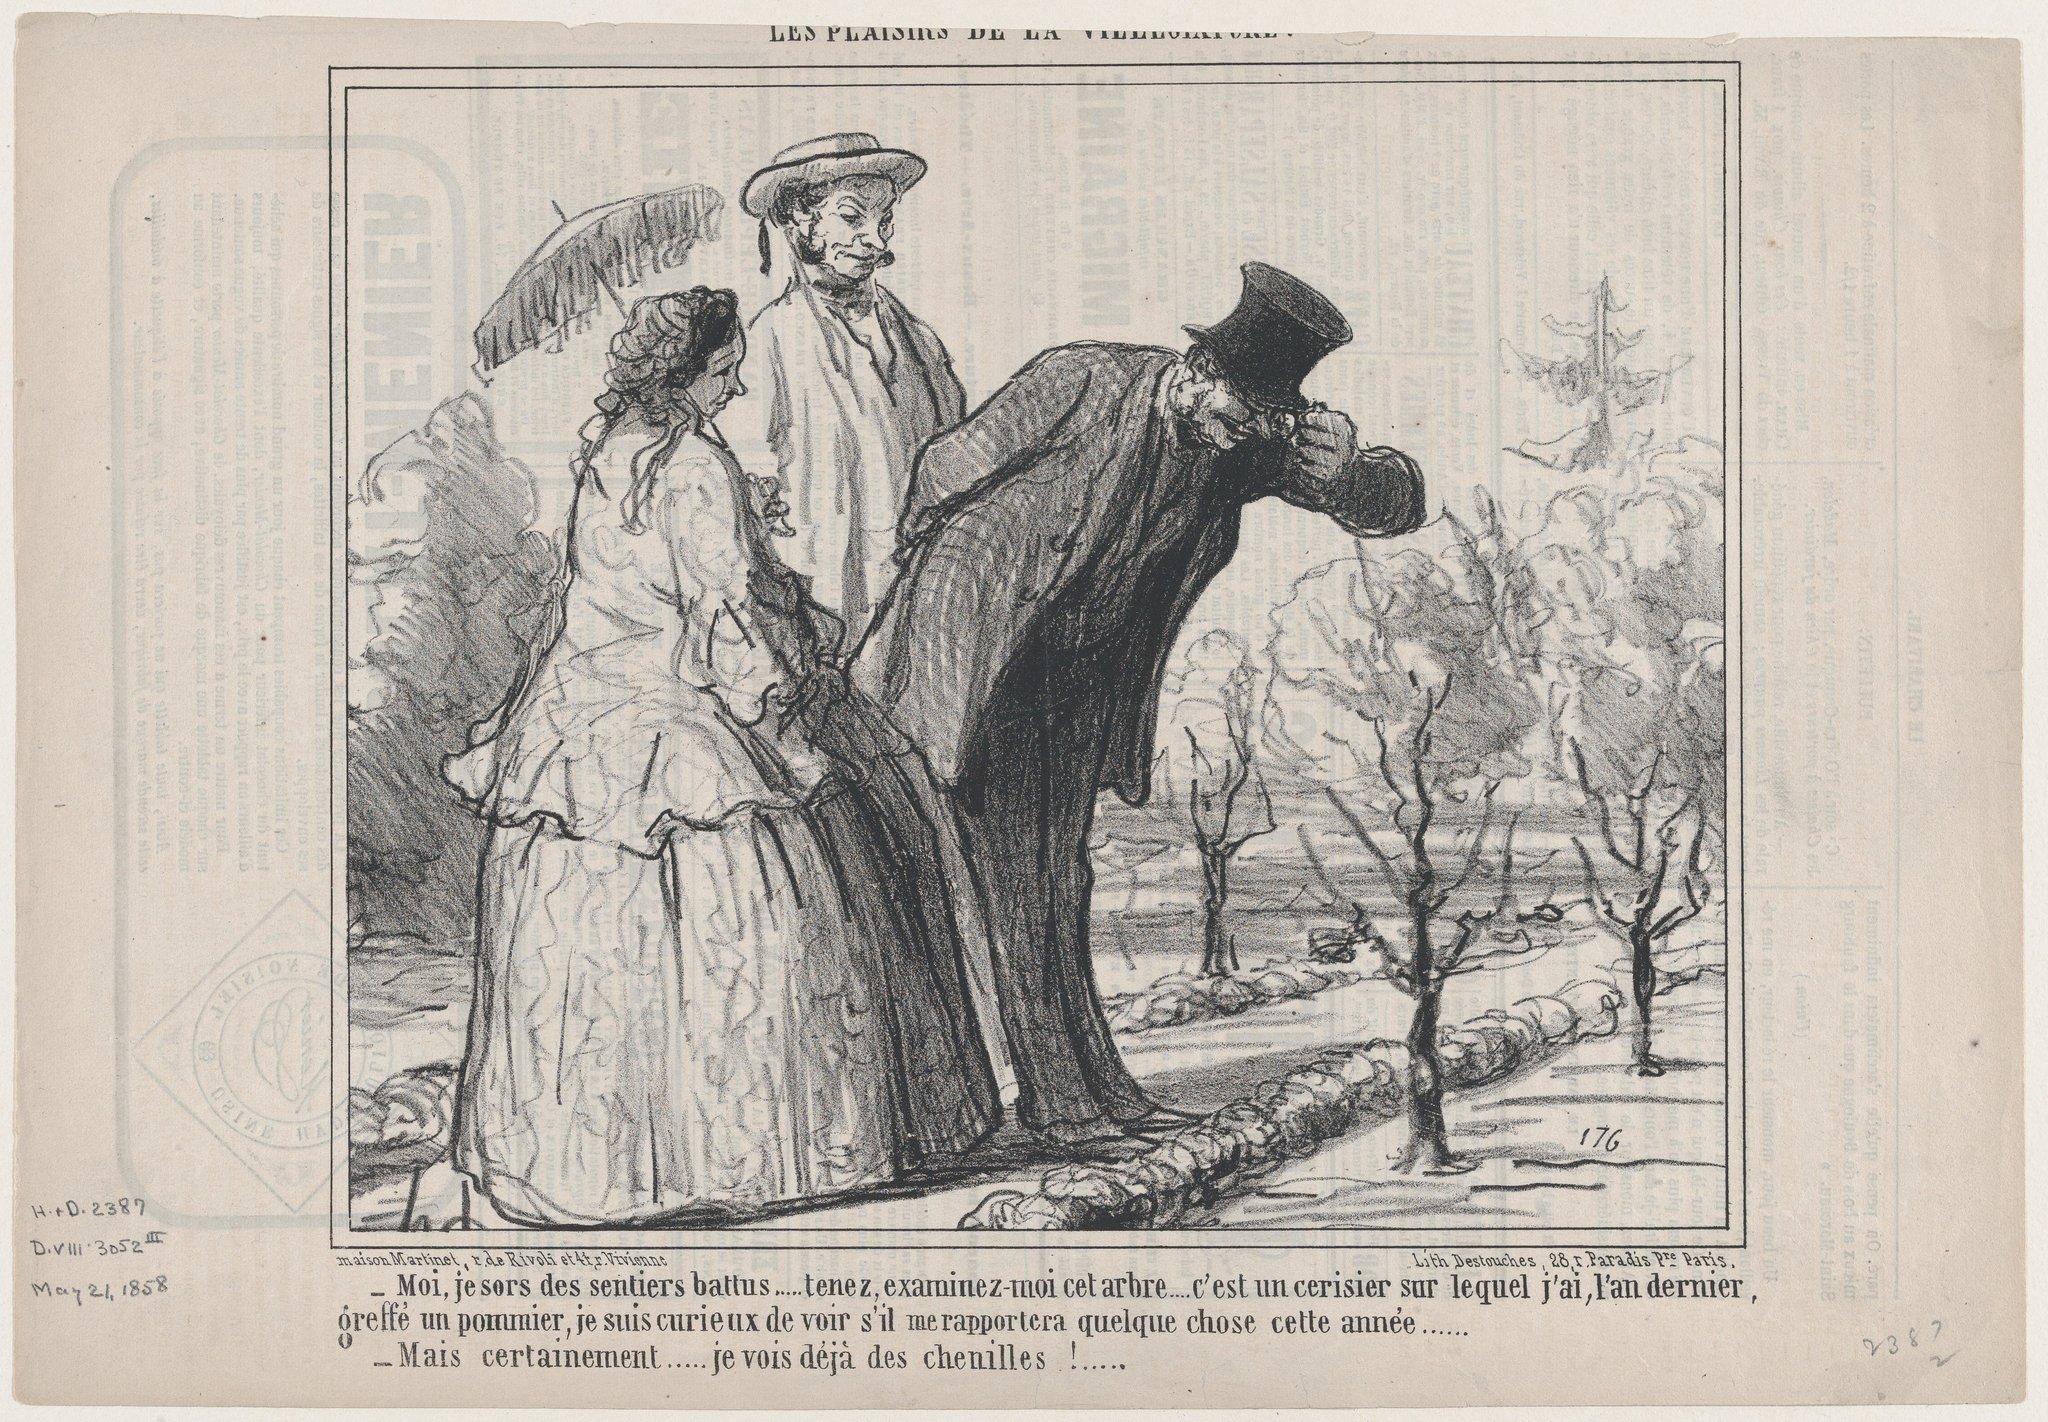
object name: print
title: Moi, jè sors de sentiers battus..., from "Les Plaisirs de la Villégiature"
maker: honoré daumier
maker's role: artist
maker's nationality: french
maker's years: 1808-1879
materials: paper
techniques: lithograph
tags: men,women